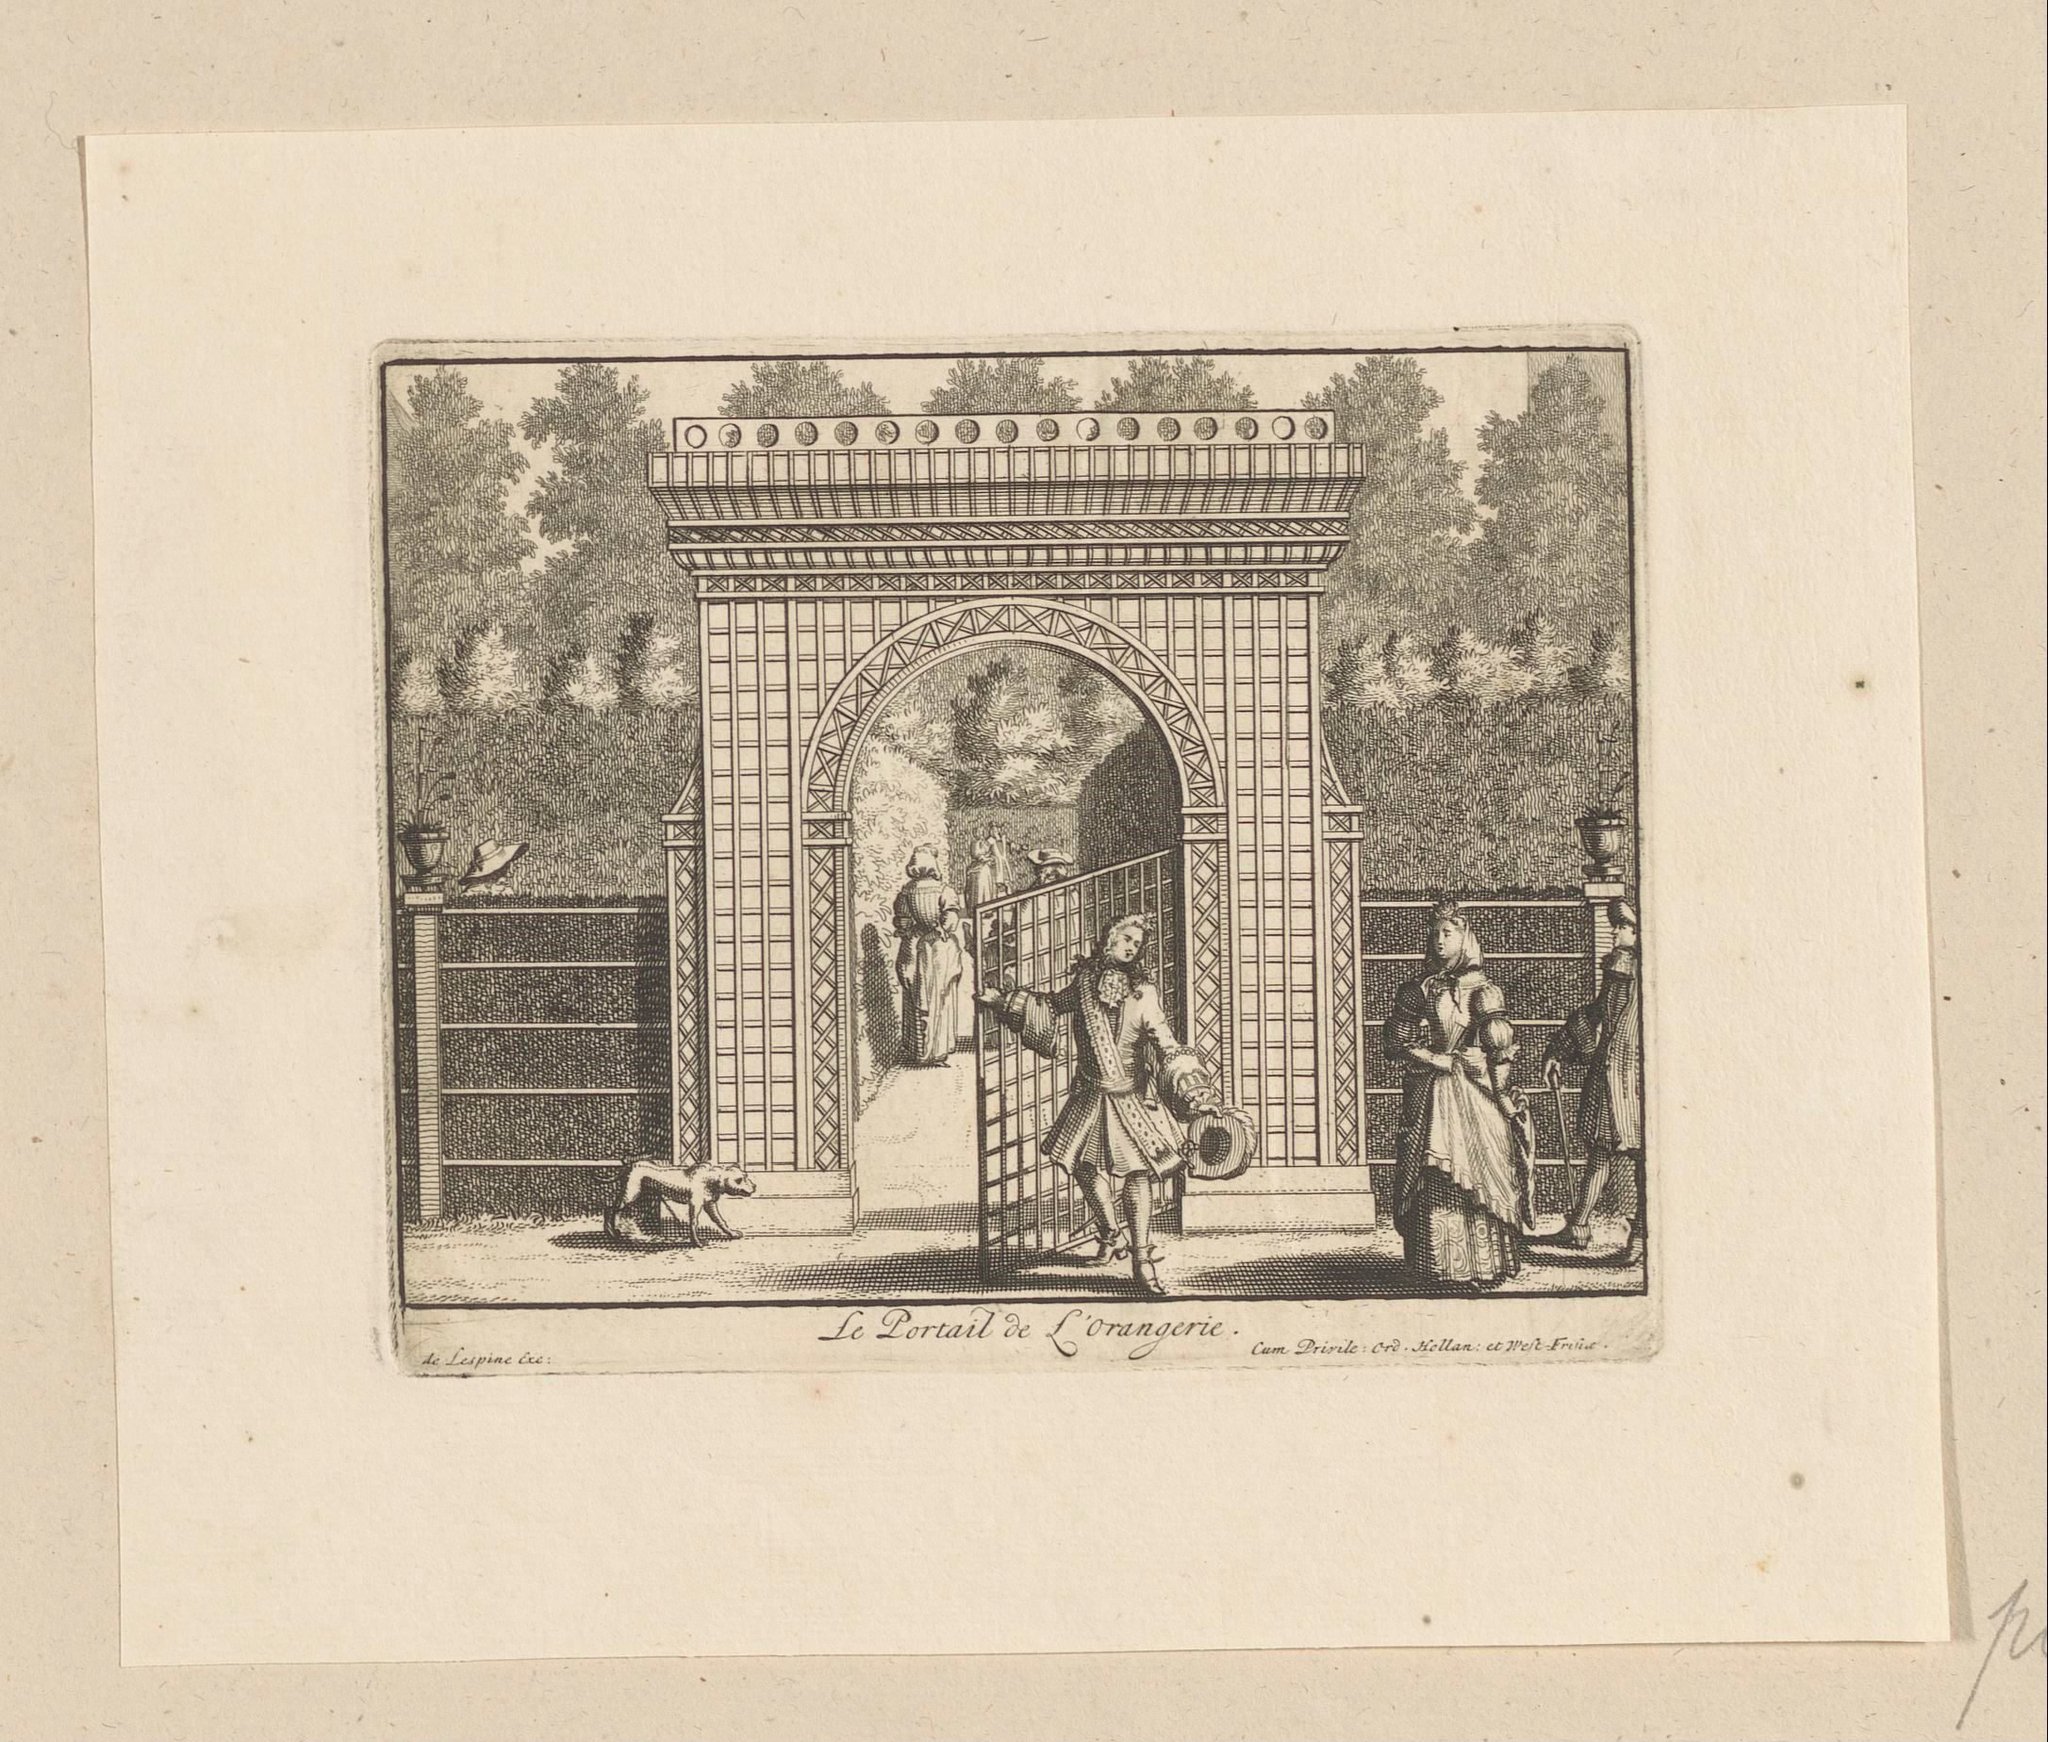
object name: print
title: Poort van de orangerie bij Kasteel Gunterstein, Breukelen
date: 1680-1696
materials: paper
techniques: engraving, etching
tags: magdalena poulle, gate, entrance, greenhouse, orangery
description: De toegangspoort tot de tuin rond de orangerie bij Kasteel Gunterstein te Breukelen. Een man opent het hek. Links een hond, rechts een vrouw en een man.